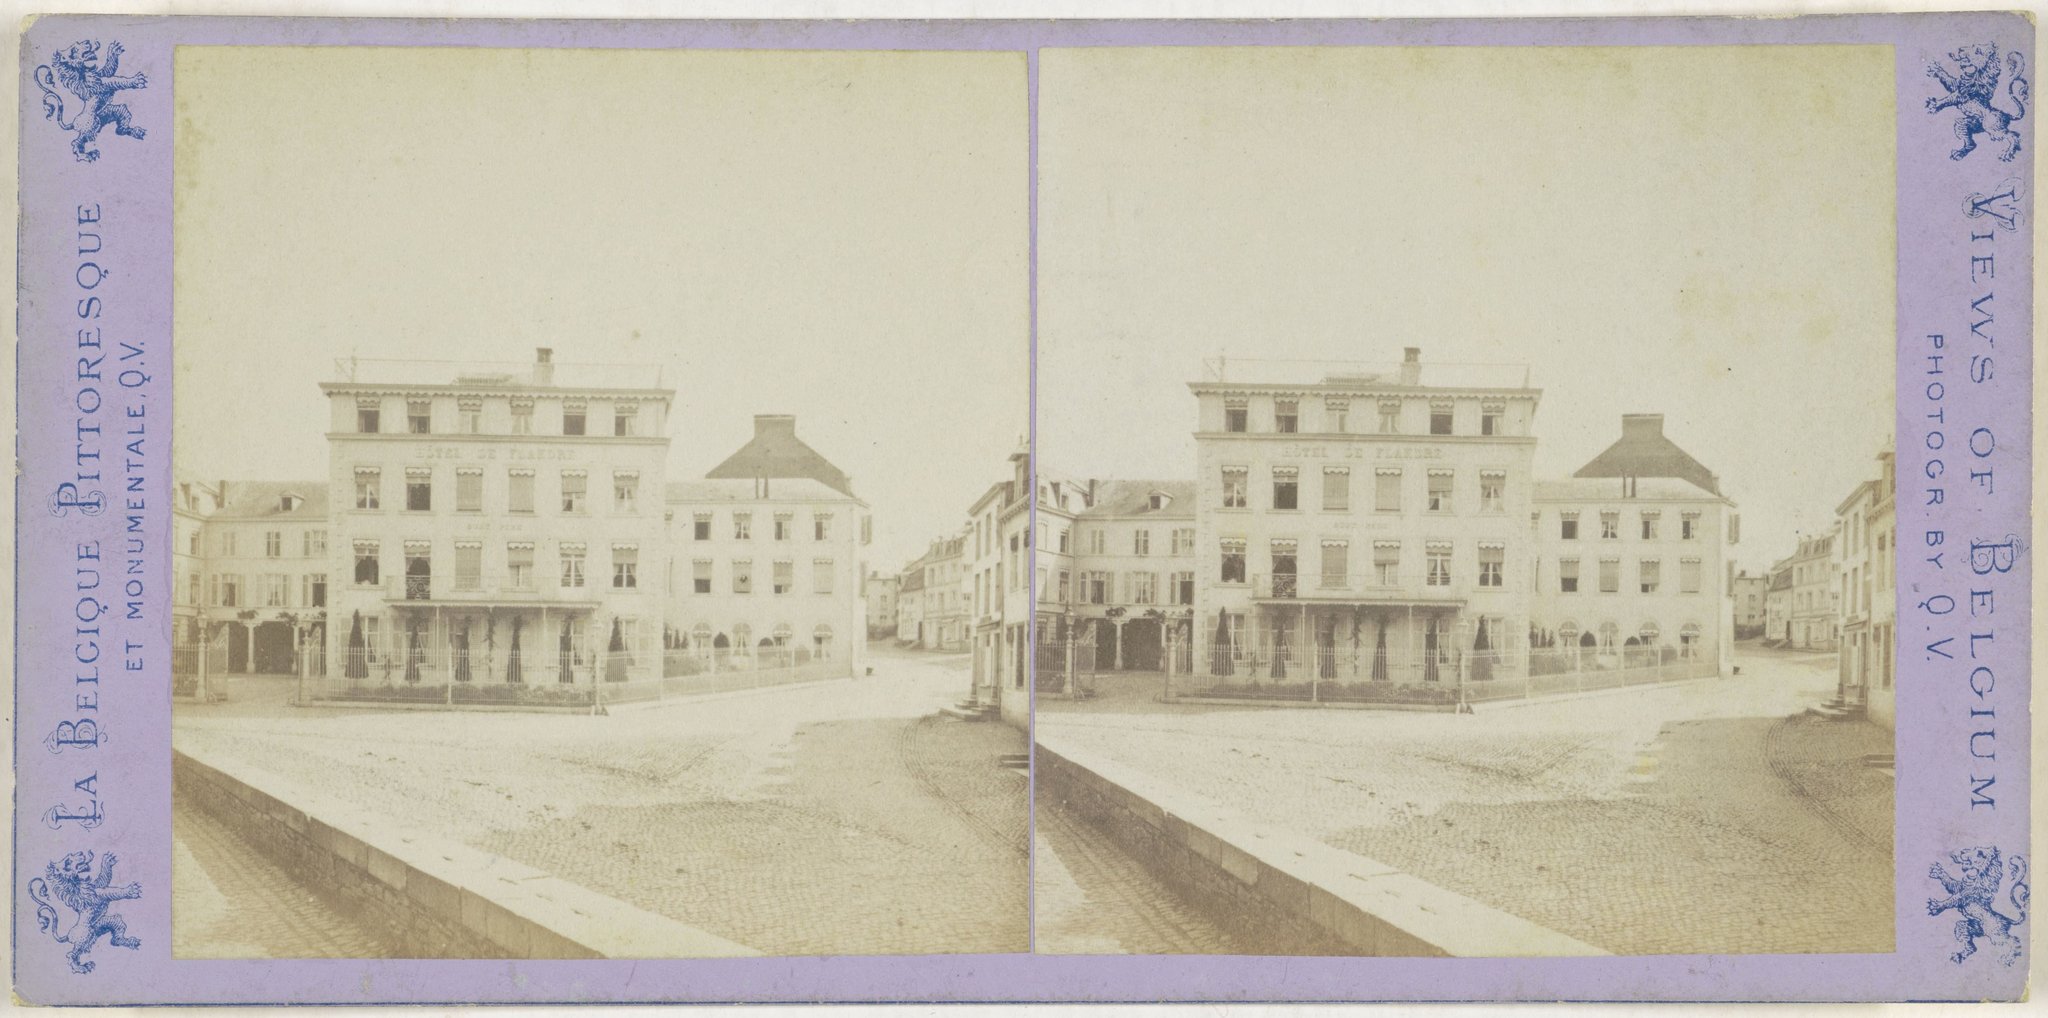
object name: stereograph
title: Gezicht op het Hotel de Flandre in Spa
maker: jules hippolyte quéval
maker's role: publisher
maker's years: 1824-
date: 1866-1870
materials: cardboard, paper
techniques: albumen print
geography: spa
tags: urban housing, village square, place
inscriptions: number: ‘No 1781’